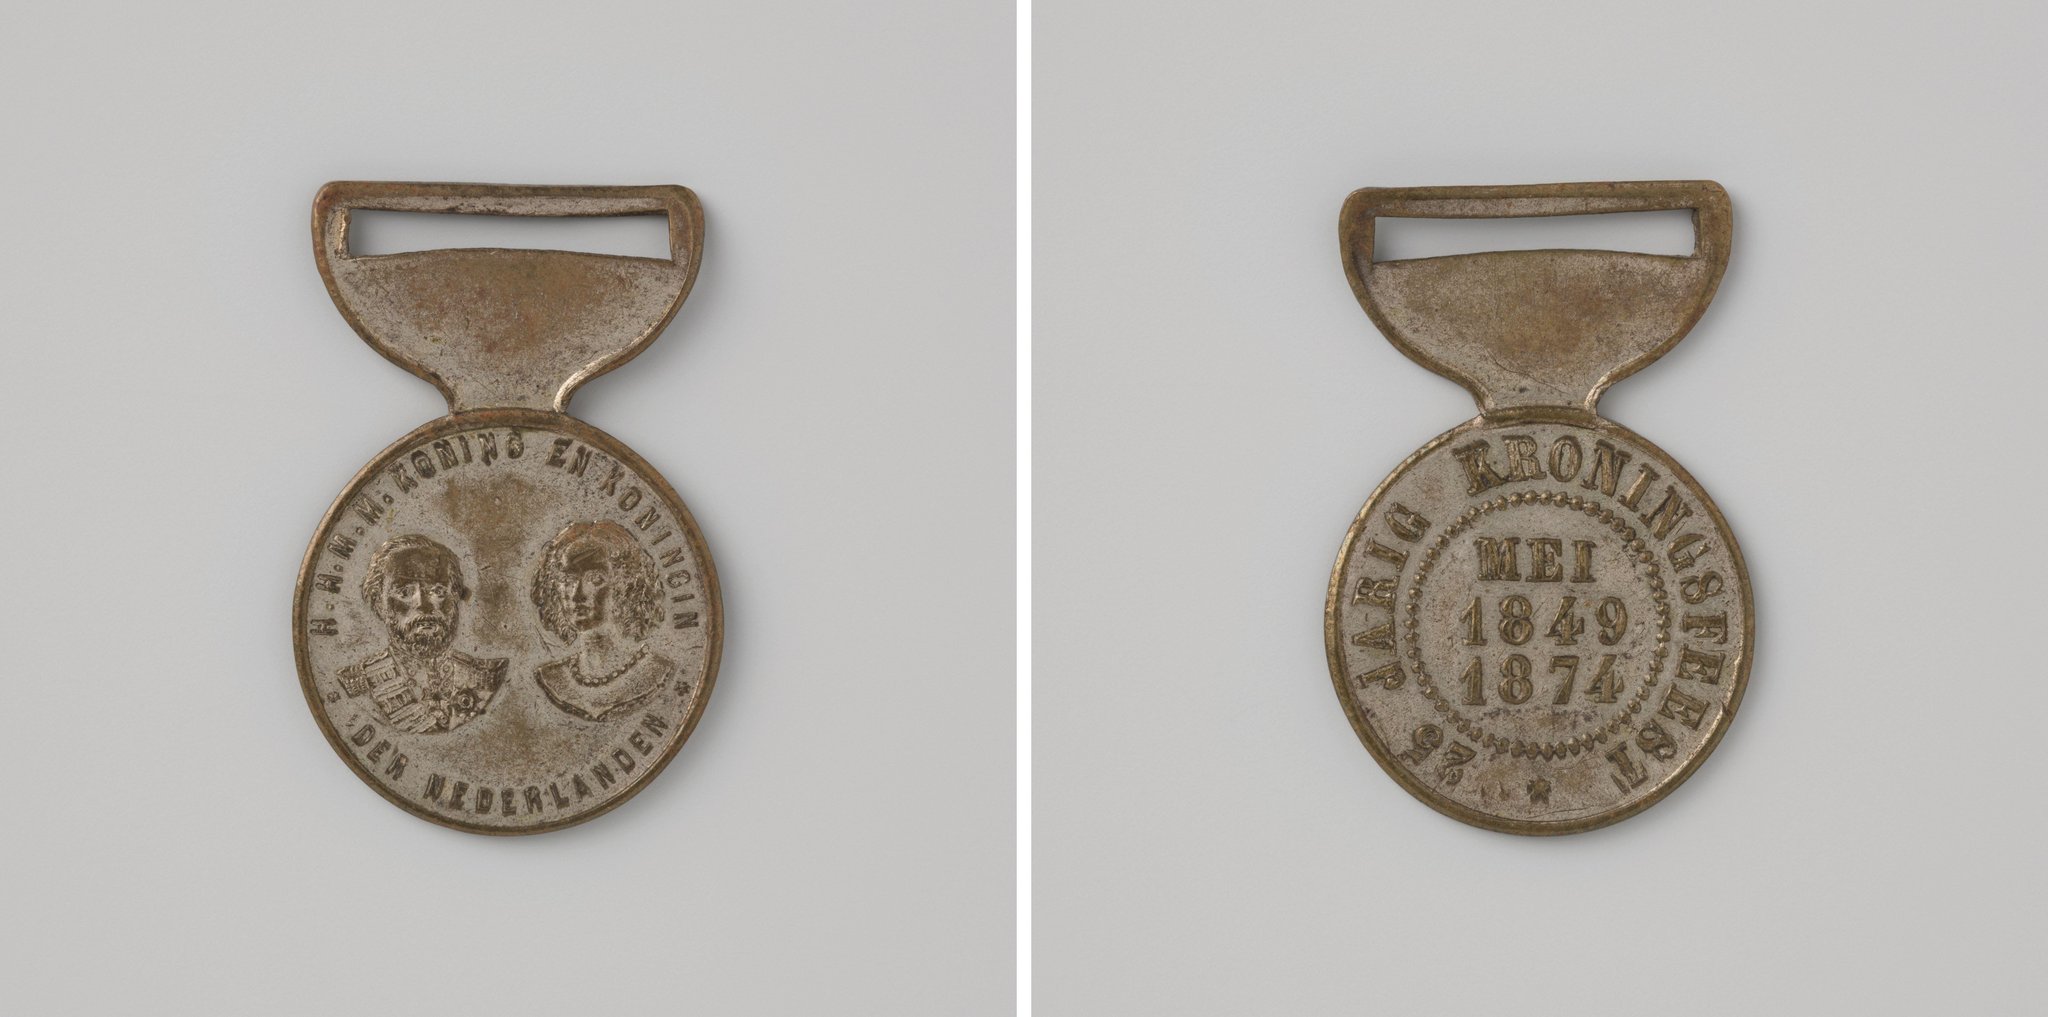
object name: history medal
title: Vijfentwintigjarig regeringsjubileuwm van koning Willem III en koningin Sophia 1874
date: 1874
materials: brass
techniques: striking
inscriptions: circumscription: ‘H.H.M.M. KONING EN KONINGIN / DER NEDERLANDEN’, circumscription: ‘25 JARIG KRONINGSFEEST’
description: Draaggesp met medaillon van verzilverd messing, op de voorzijde de aanziende portretten van Willem III en Sophia met omschrift, op de keerzijde drie regels tekst met omschrift.